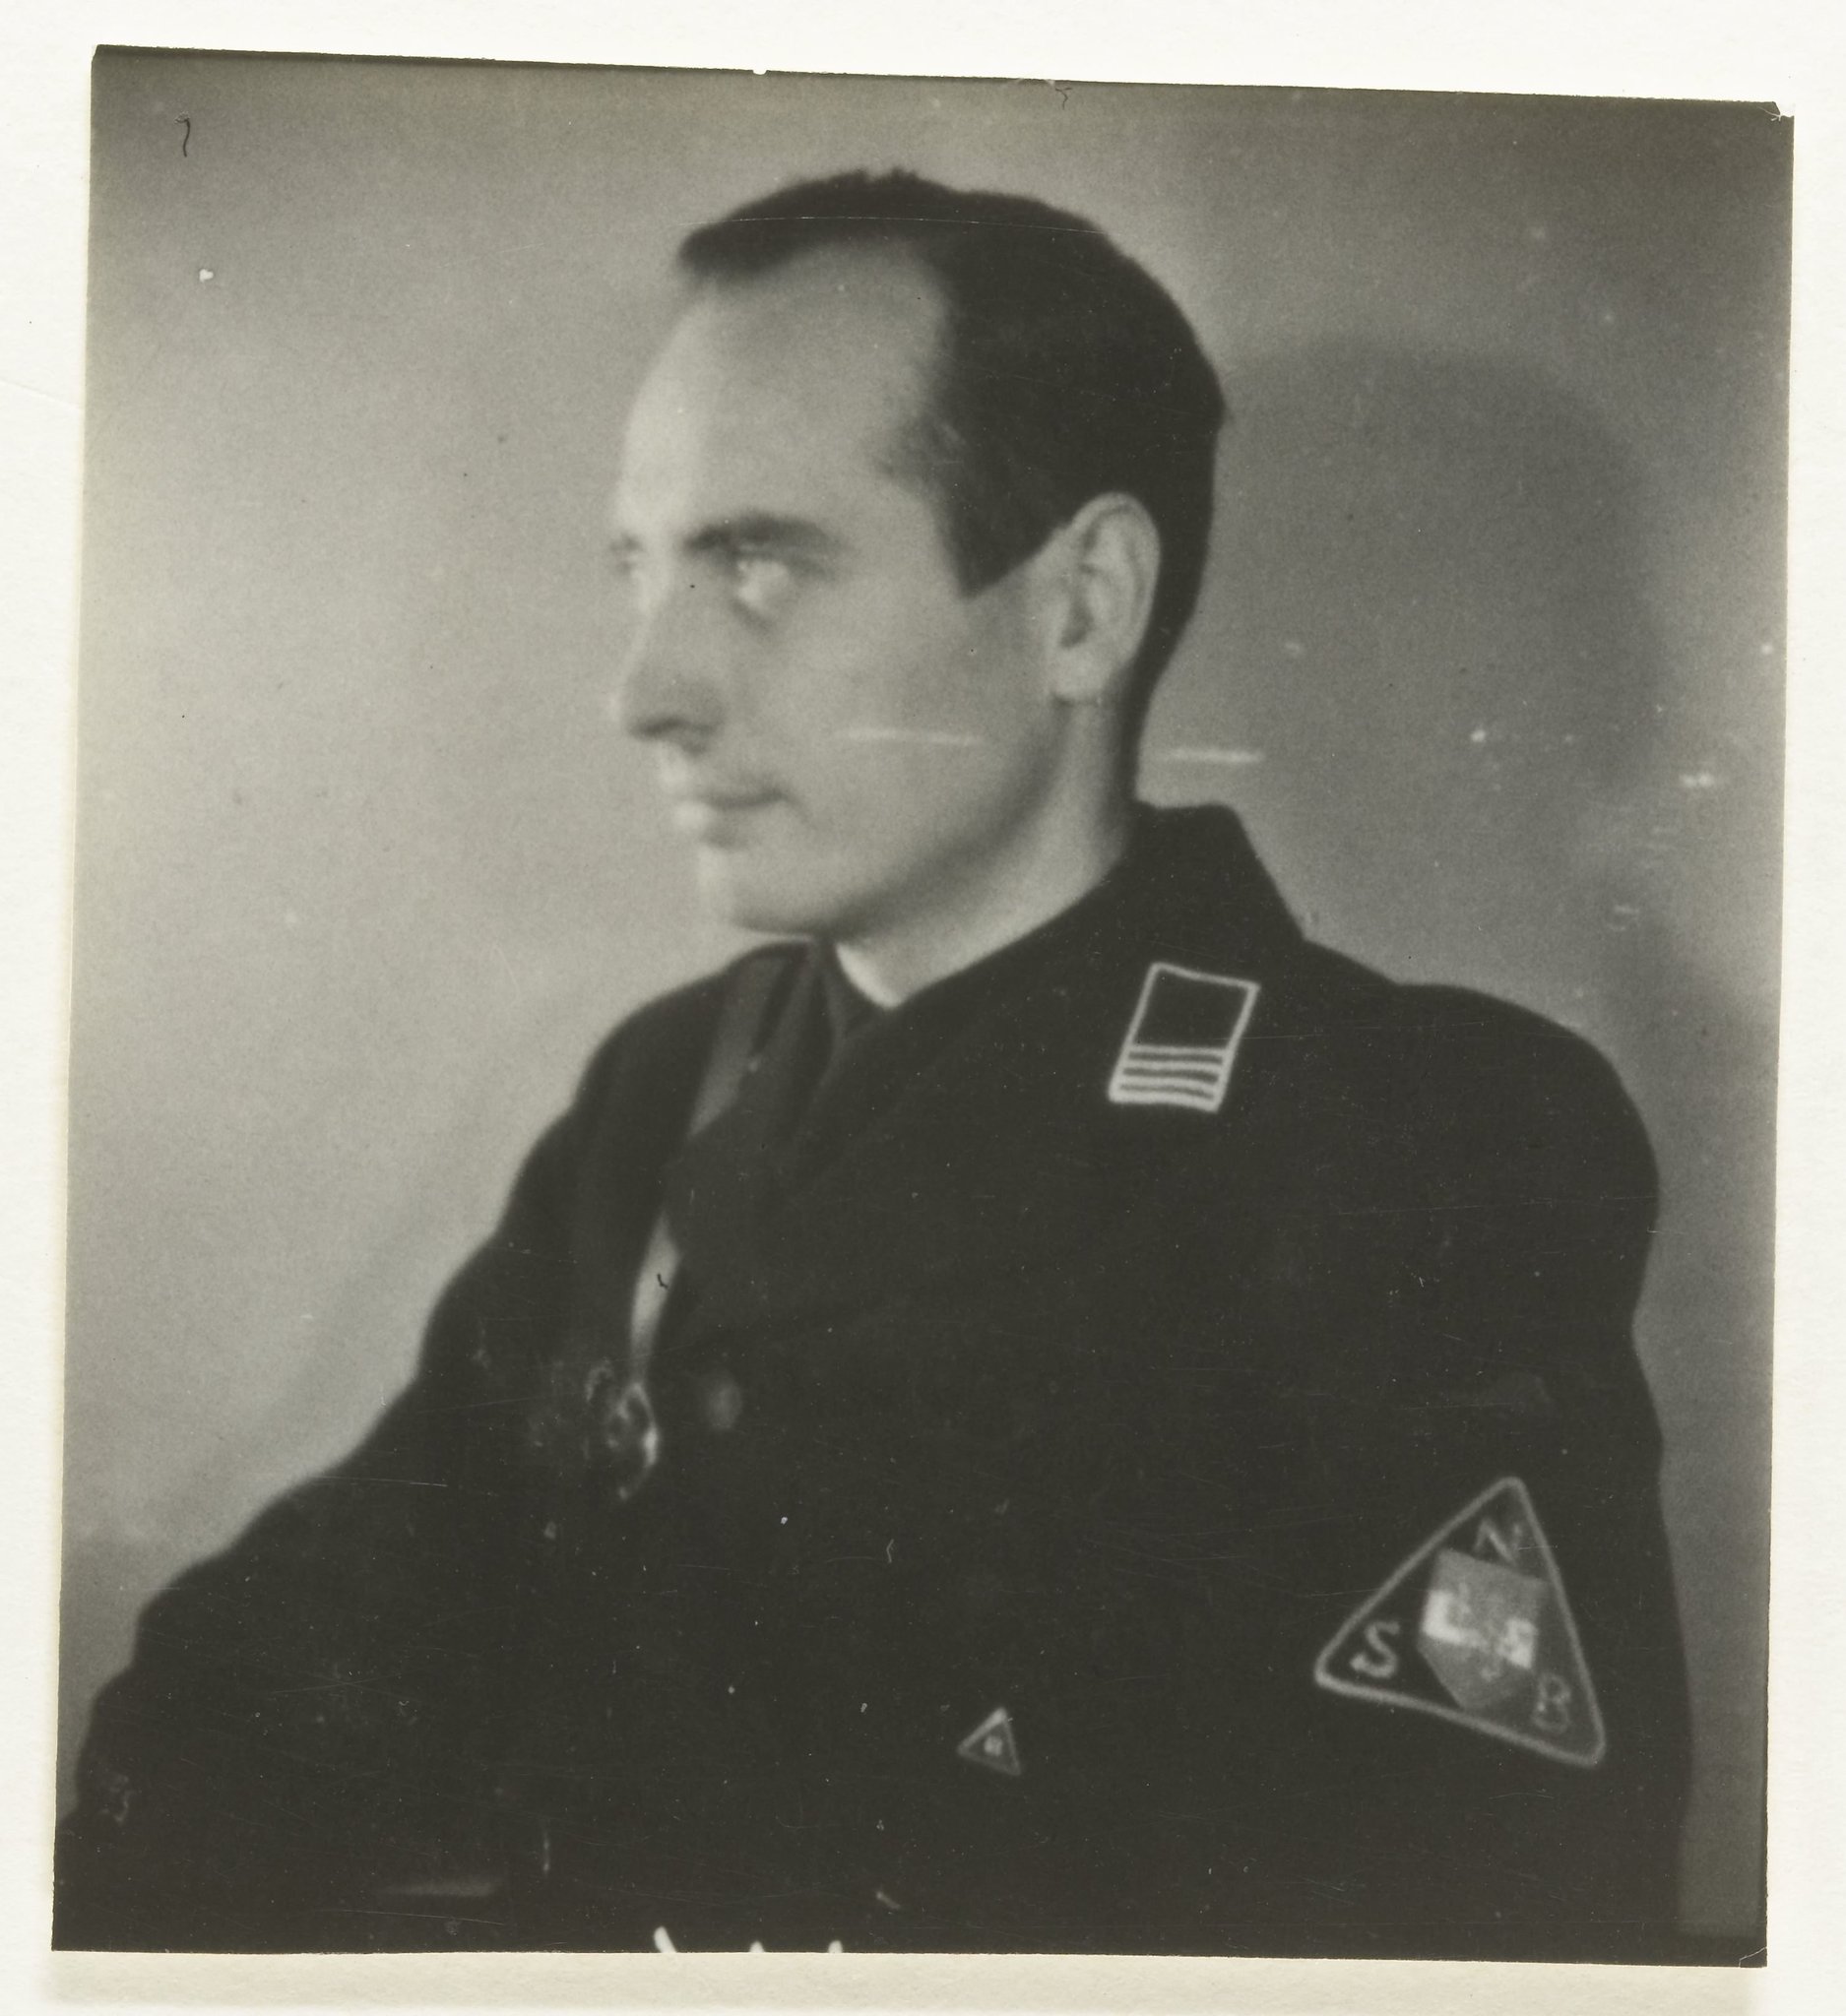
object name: contact print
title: NSB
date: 1940-1944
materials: photographic support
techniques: gelatin silver print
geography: netherlands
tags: anonymous historical person portrayed, netherlands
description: Portret van een lid van de NSB. Op zijn kraag een distinctief met drie strepen: Kringvertegenwoordiger Fronten en Gilden (Kring was de kleinste eenheid binnen een Front of Gilde). Riem schuin over de borst, op de linkermouw het driehoekige NSB embleem. Bijna en profil gefotografeerd. Blootshoofd.